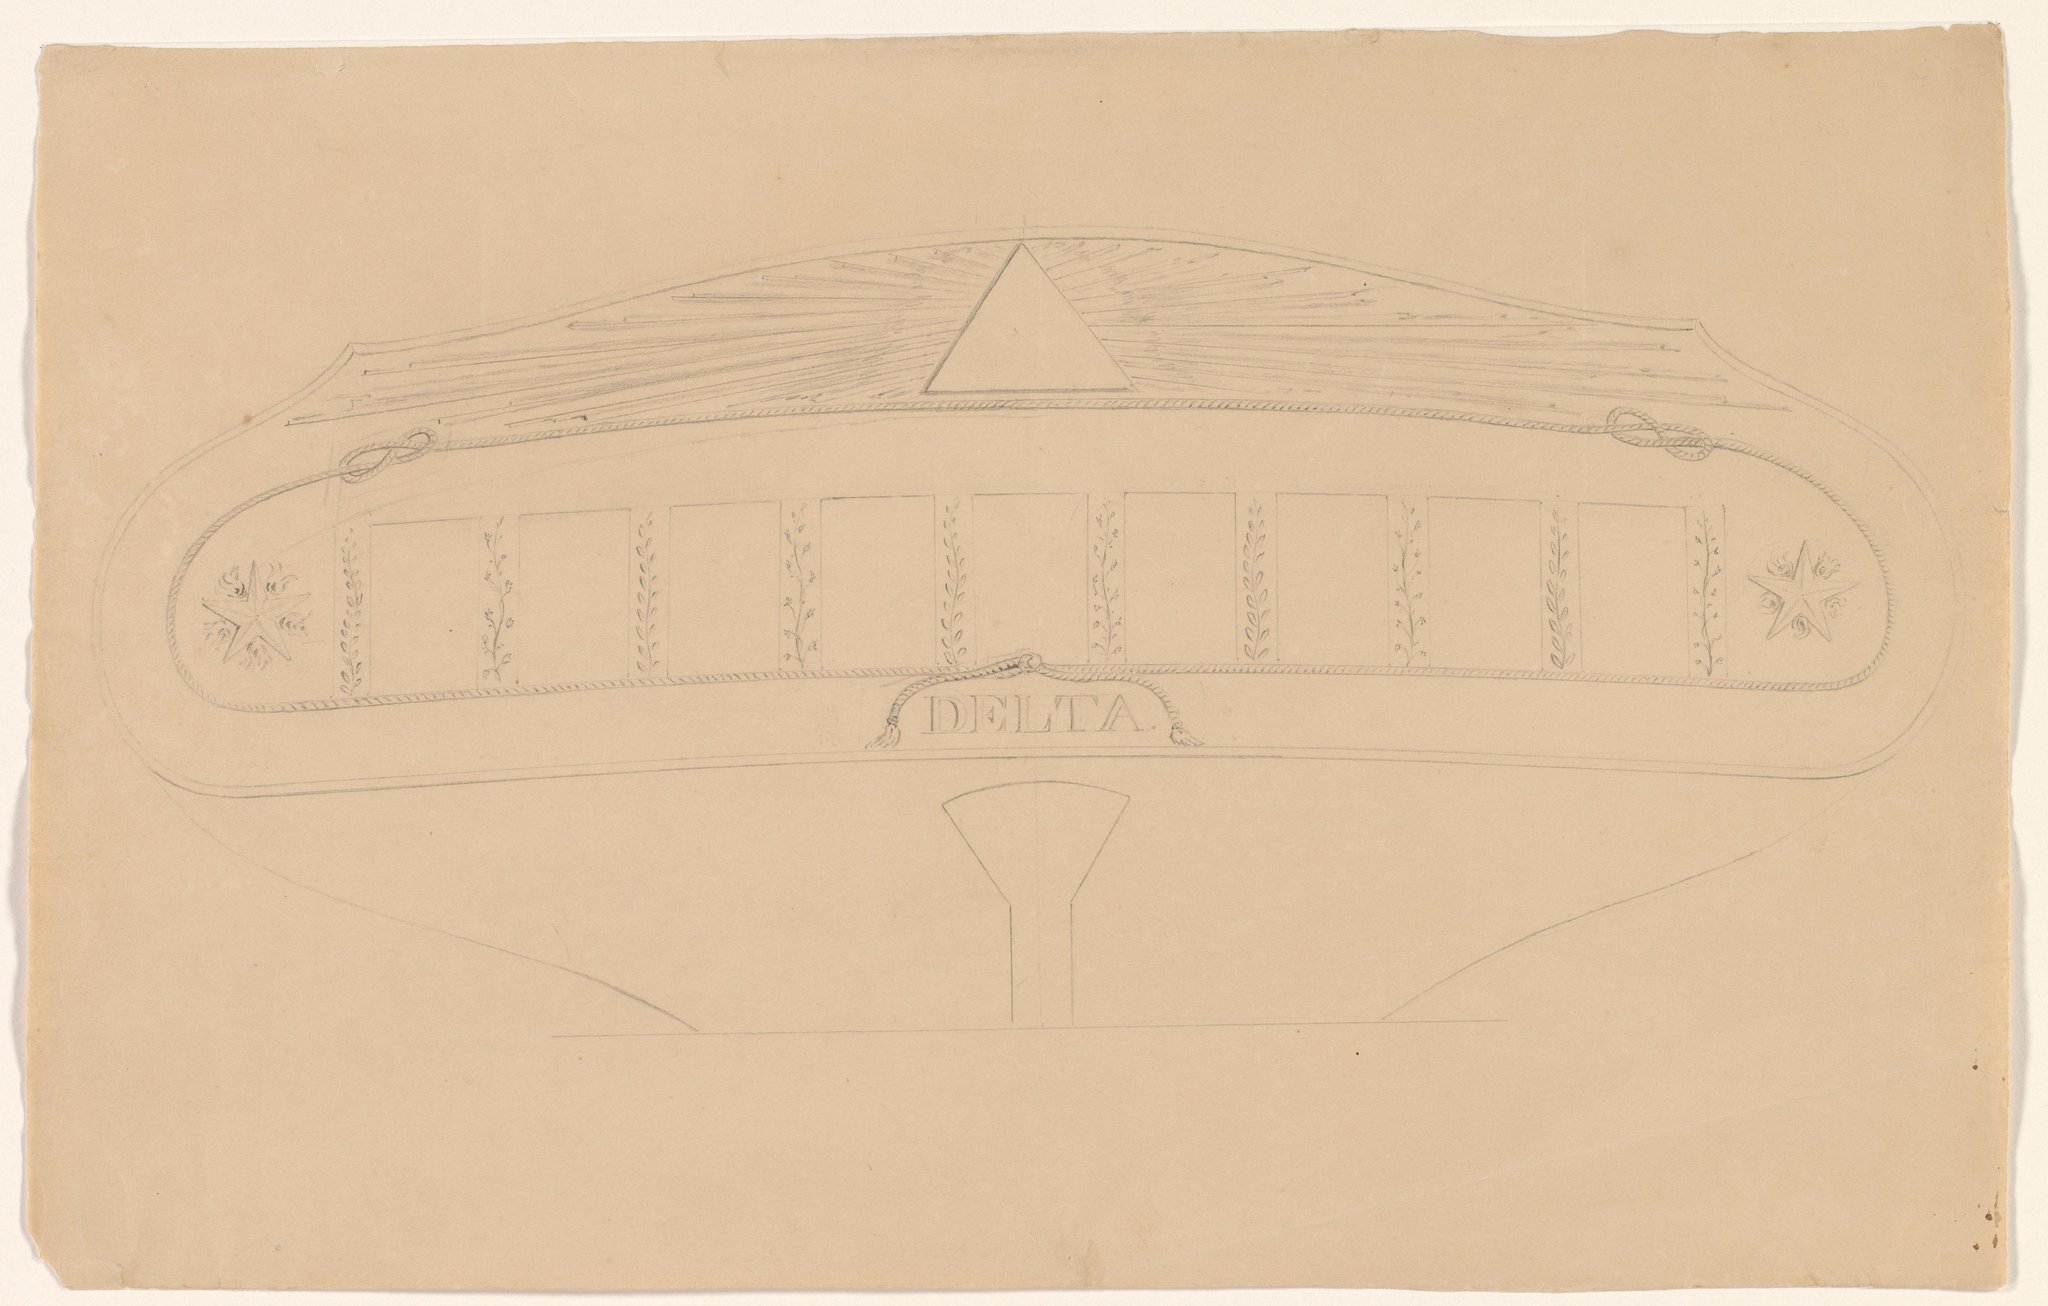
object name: drawing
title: Ontwerp voor de decoratie van de spiegel van het fregat Broedertrouw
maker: a.j. schouten (1775-1849)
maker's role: architect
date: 1837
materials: paper, pencil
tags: parts of ship's exterior: stern, ornamenting, decorating ~ applied arts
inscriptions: inscription: ‘Fregat Broedertrouw gebouwd in 1837’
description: Ontwerp met touwen, bloem- en bladmotieven, zuilen en strikken.